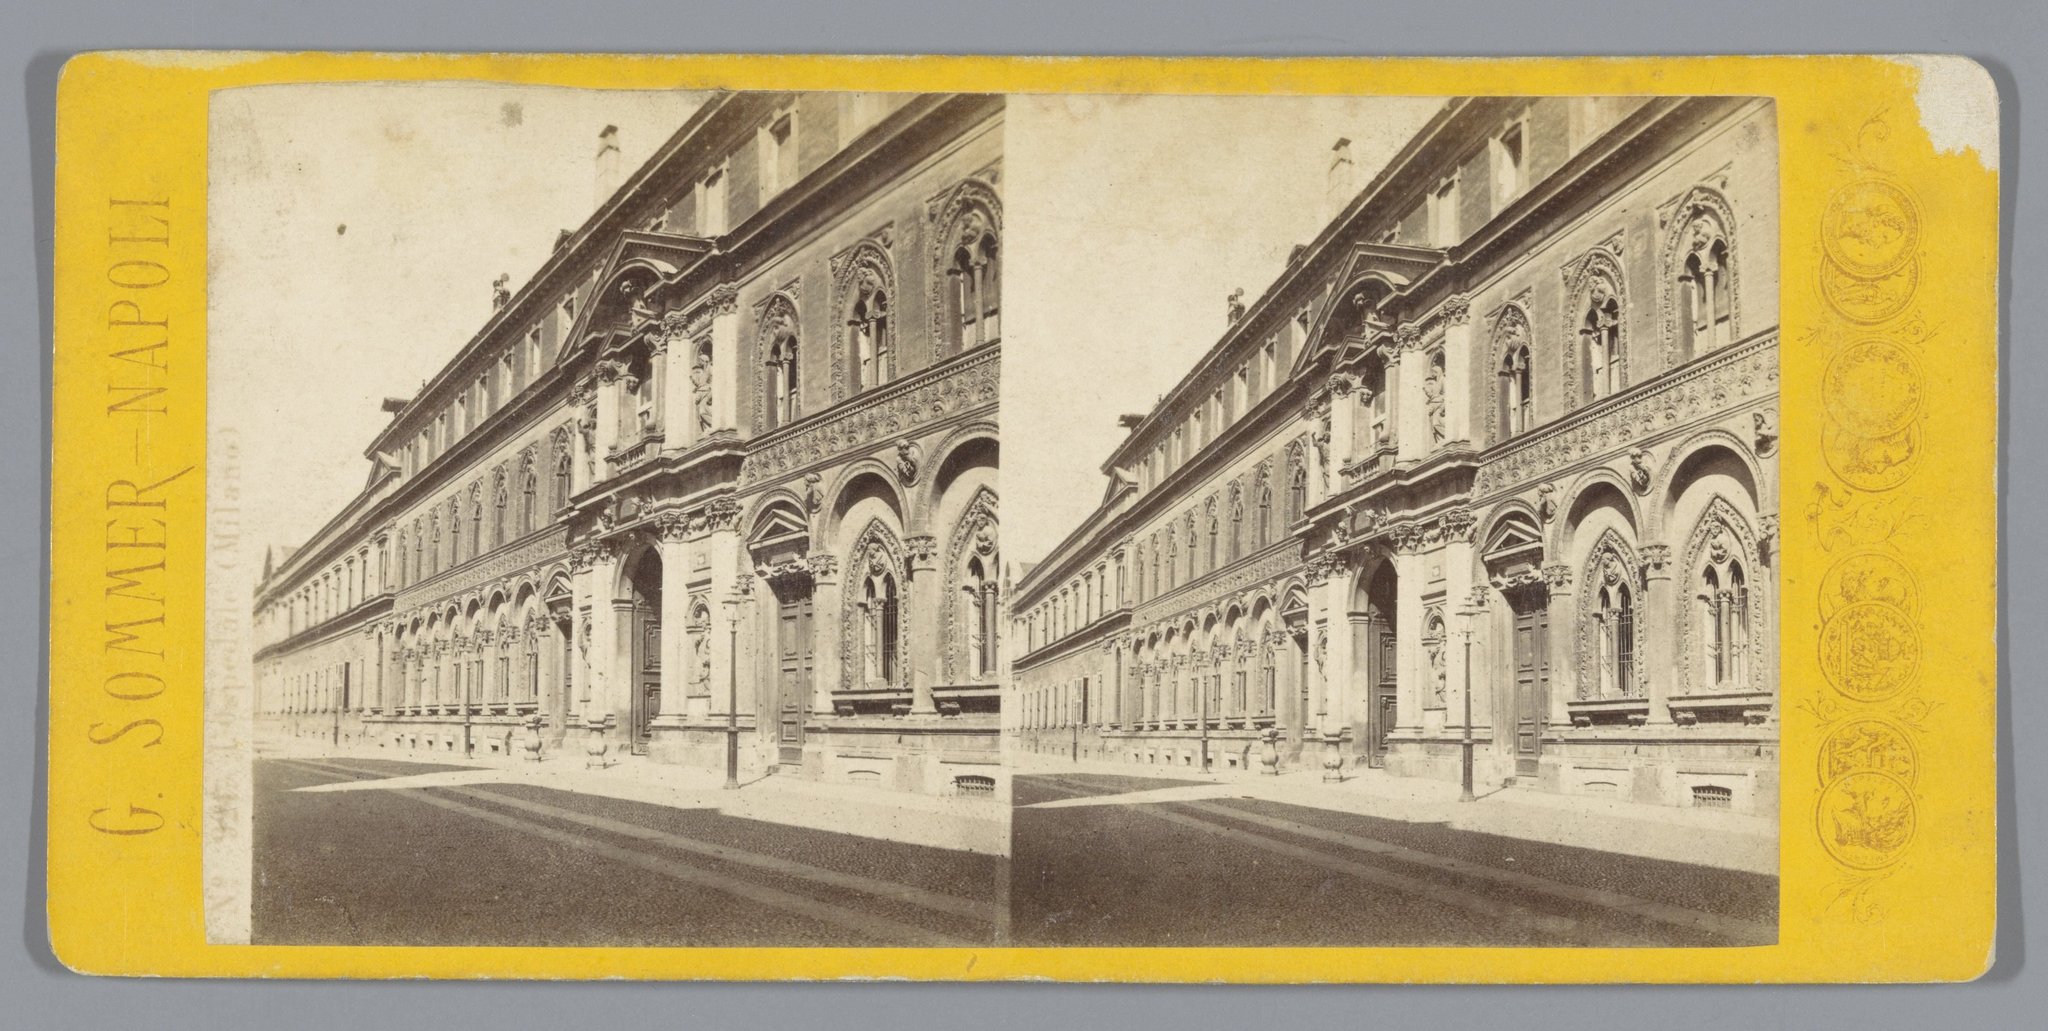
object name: stereograph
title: L'Ospedale (Milano)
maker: giorgio sommer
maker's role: fotograaf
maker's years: 1834-1914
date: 1860-1880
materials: cardboard, photographic support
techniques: albumen print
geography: milan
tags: hospital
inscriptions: inscription: ‘Milano : Ospedale’, number: ‘No. 924’